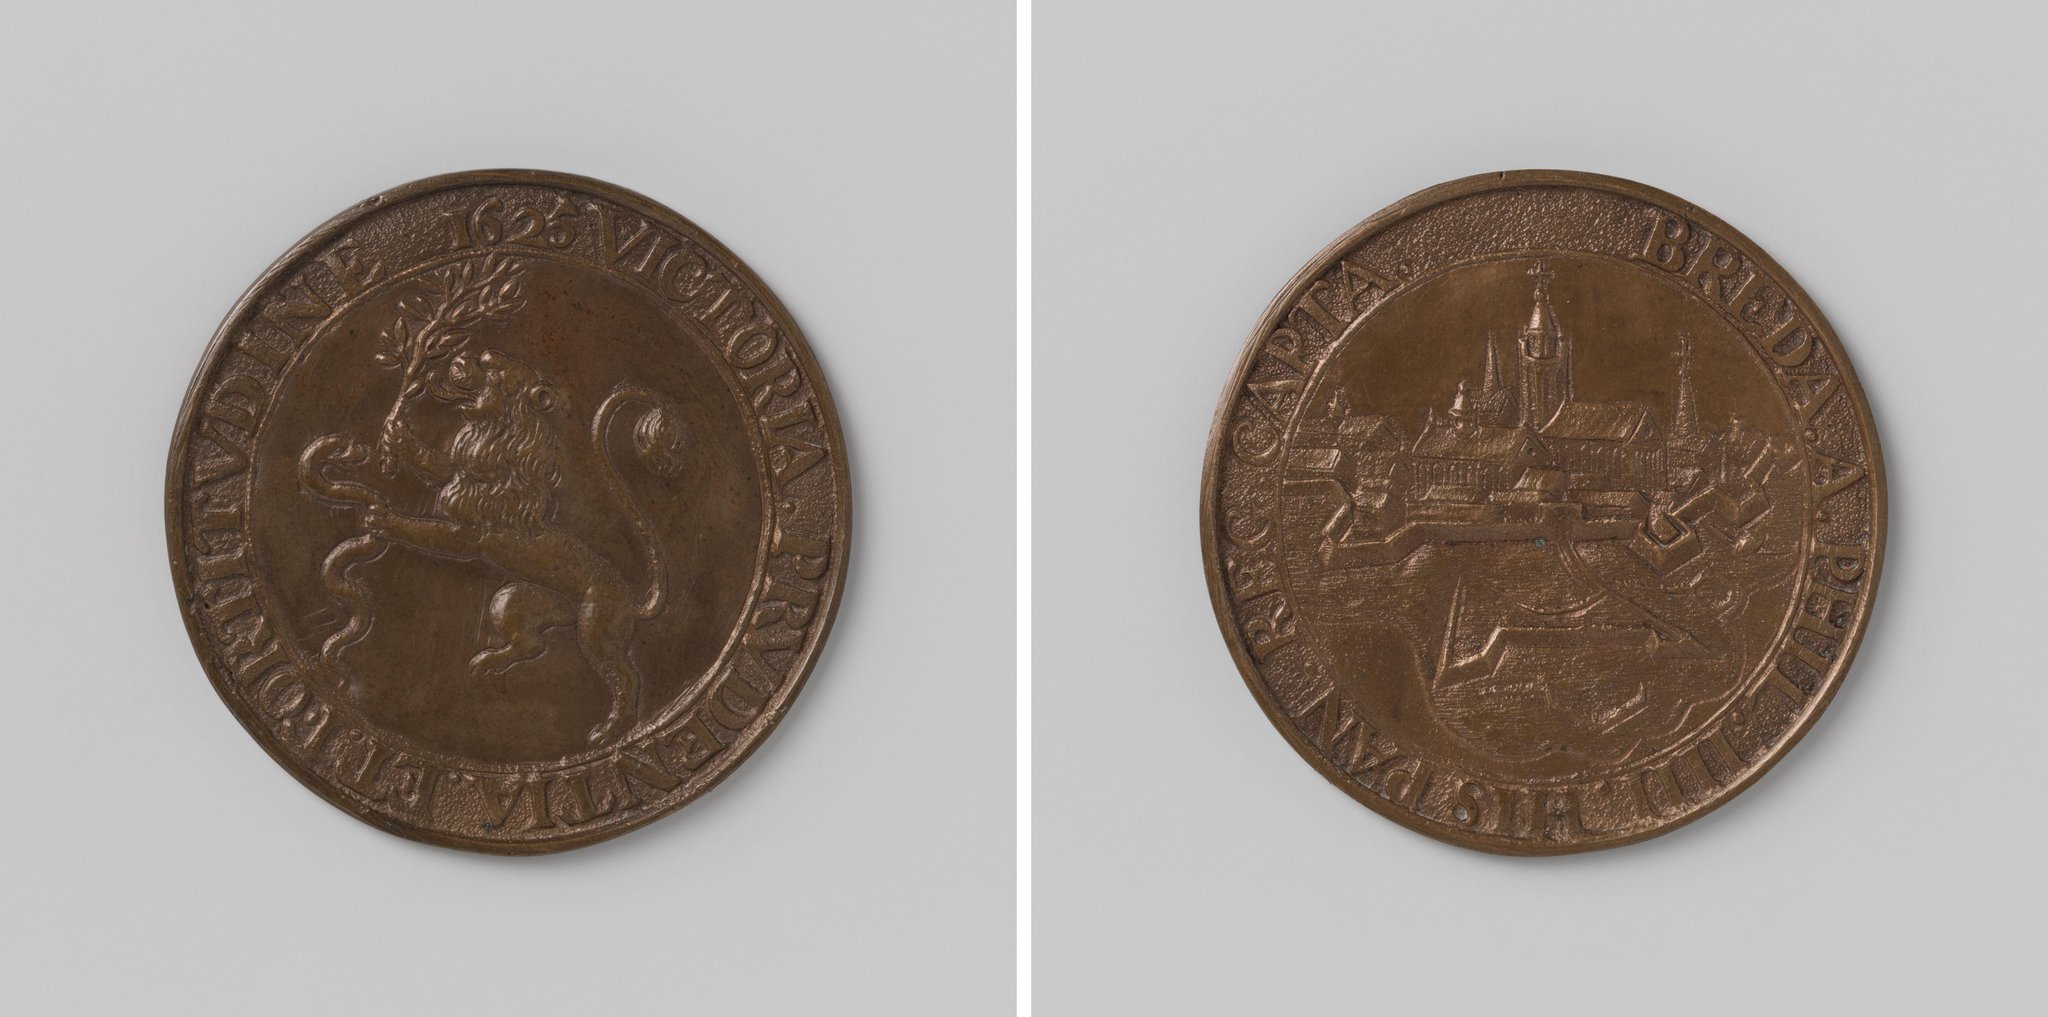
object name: history medal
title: Verovering van Breda door de Spanjaarden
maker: Anonymous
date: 1625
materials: bronze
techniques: casting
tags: breda, inname van breda (1625)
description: Bronzen penning. Voorzijde: leeuw met lauriertak en slang binnen omschrift. Keerzijde: stad binnen omschrift